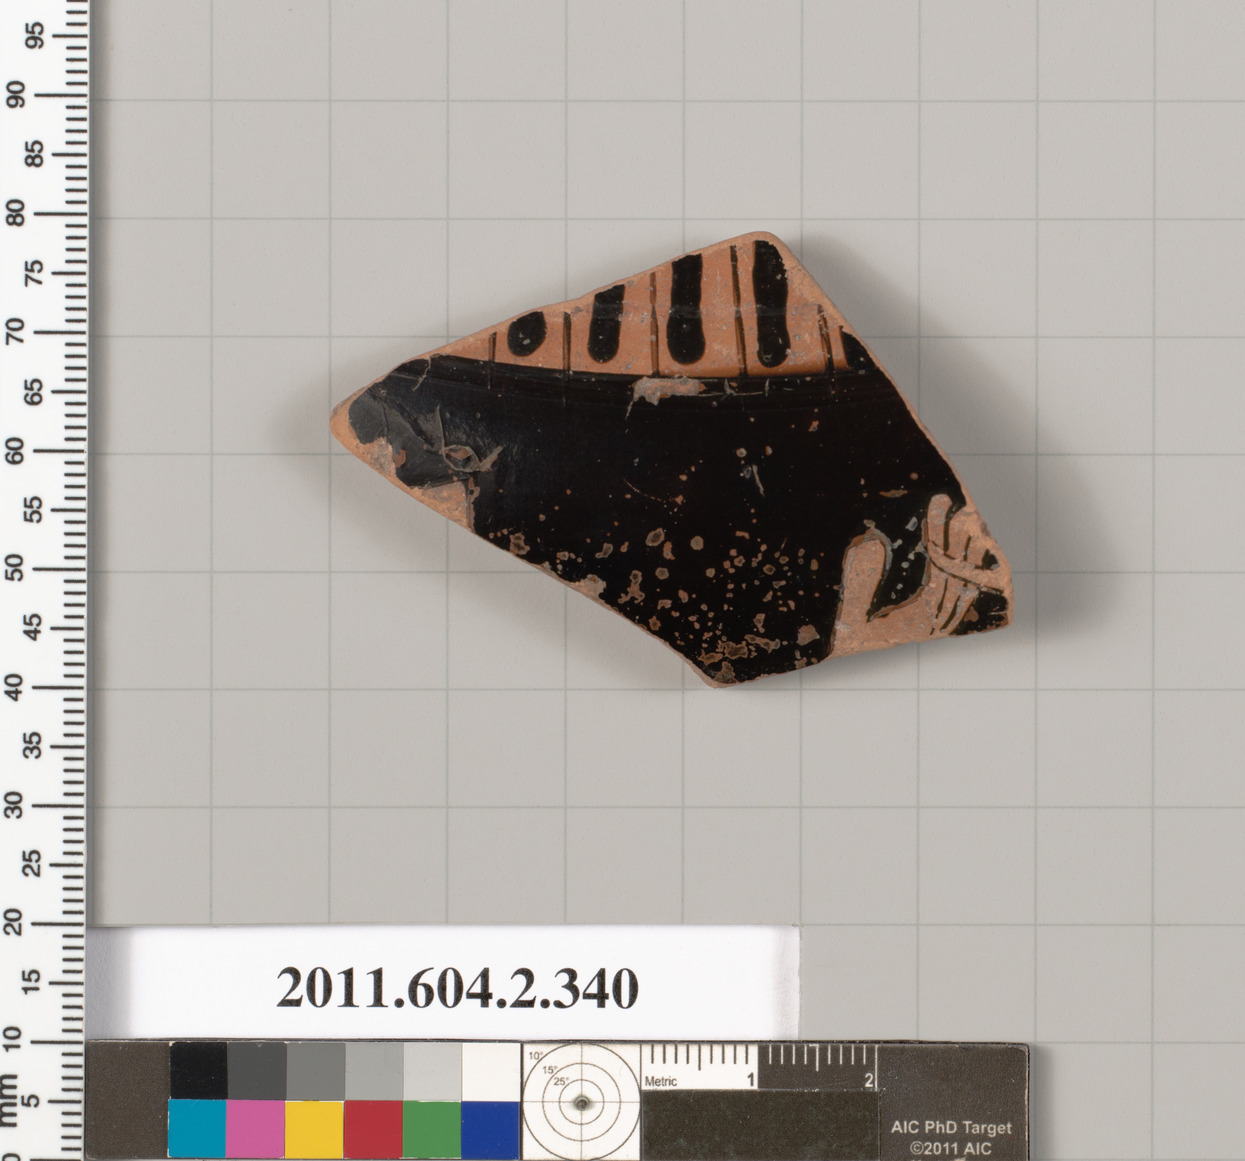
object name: column krater fragment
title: Terracotta fragment of a column-krater (bowl for mixing wine and water)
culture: greek, attic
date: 460-440 BCE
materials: terracotta